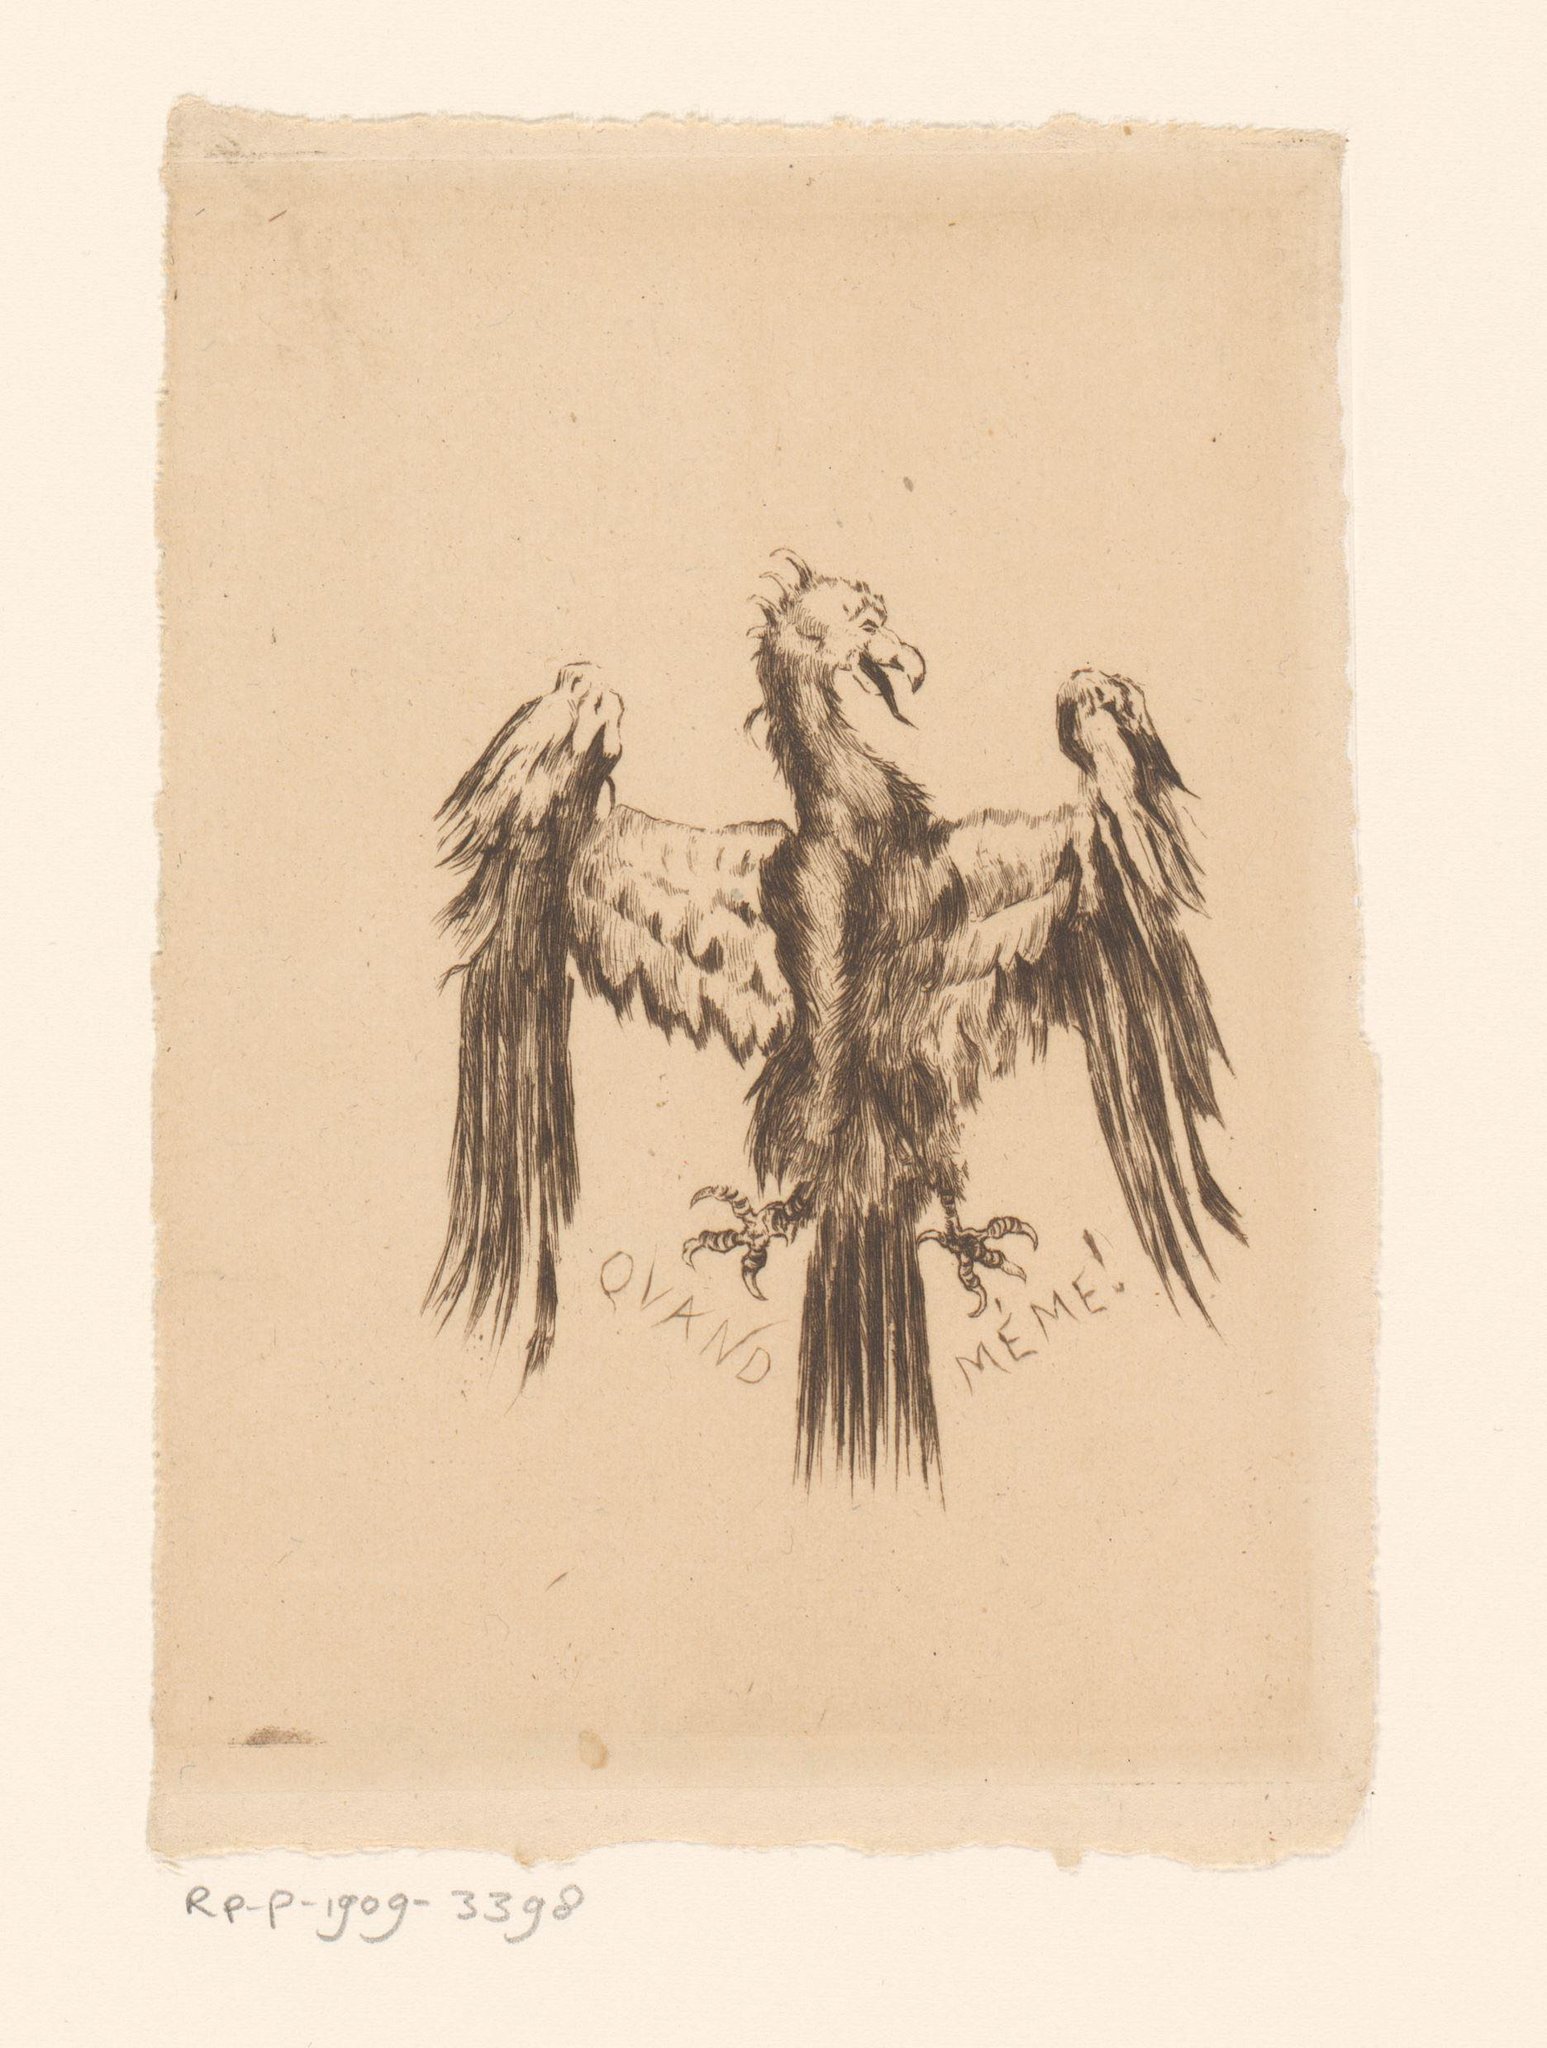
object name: print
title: Heraldische adelaar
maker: marie danse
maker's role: print maker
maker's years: 1867-1942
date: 1877-1909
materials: paper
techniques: etching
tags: predatory birds: eagle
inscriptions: collector's mark: Lugt 2228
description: Bij de adelaar staat de spreuk: "Quand mème!".